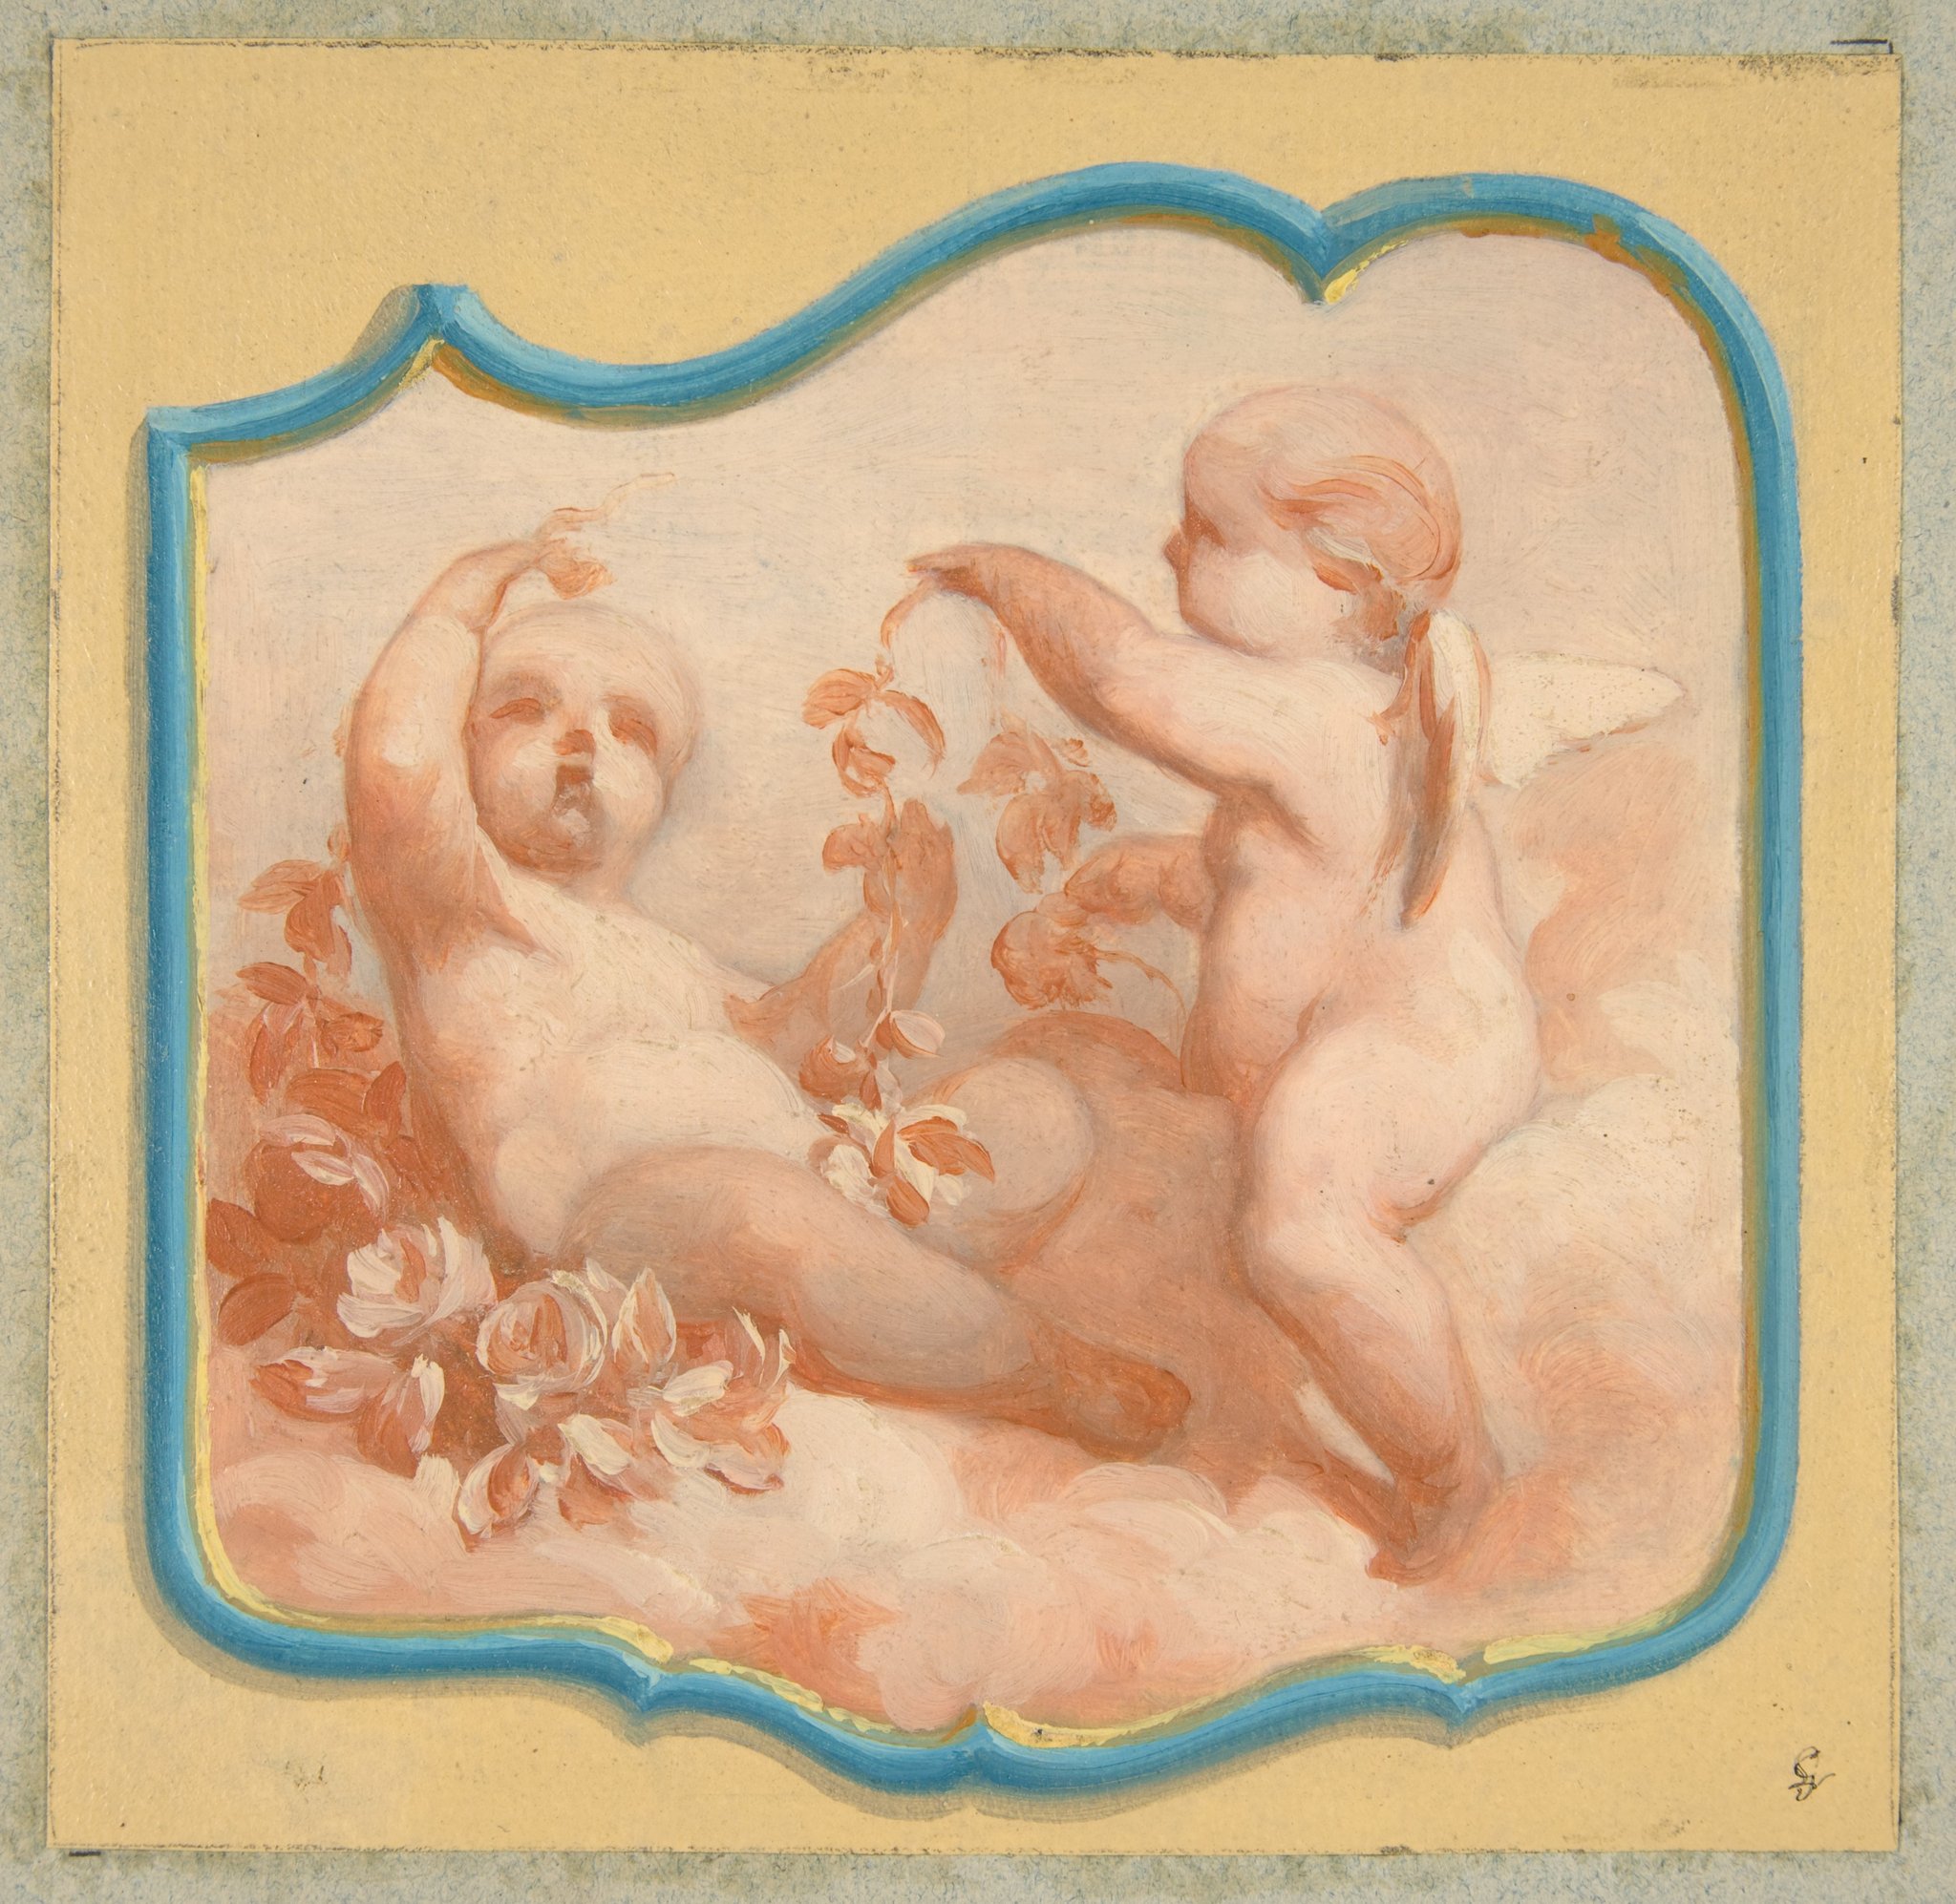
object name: drawing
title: Two putti seated on clouds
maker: jules-edmond-charles lachaise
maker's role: artist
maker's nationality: french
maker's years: 1897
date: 1851-1900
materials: graphite, oil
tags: putti